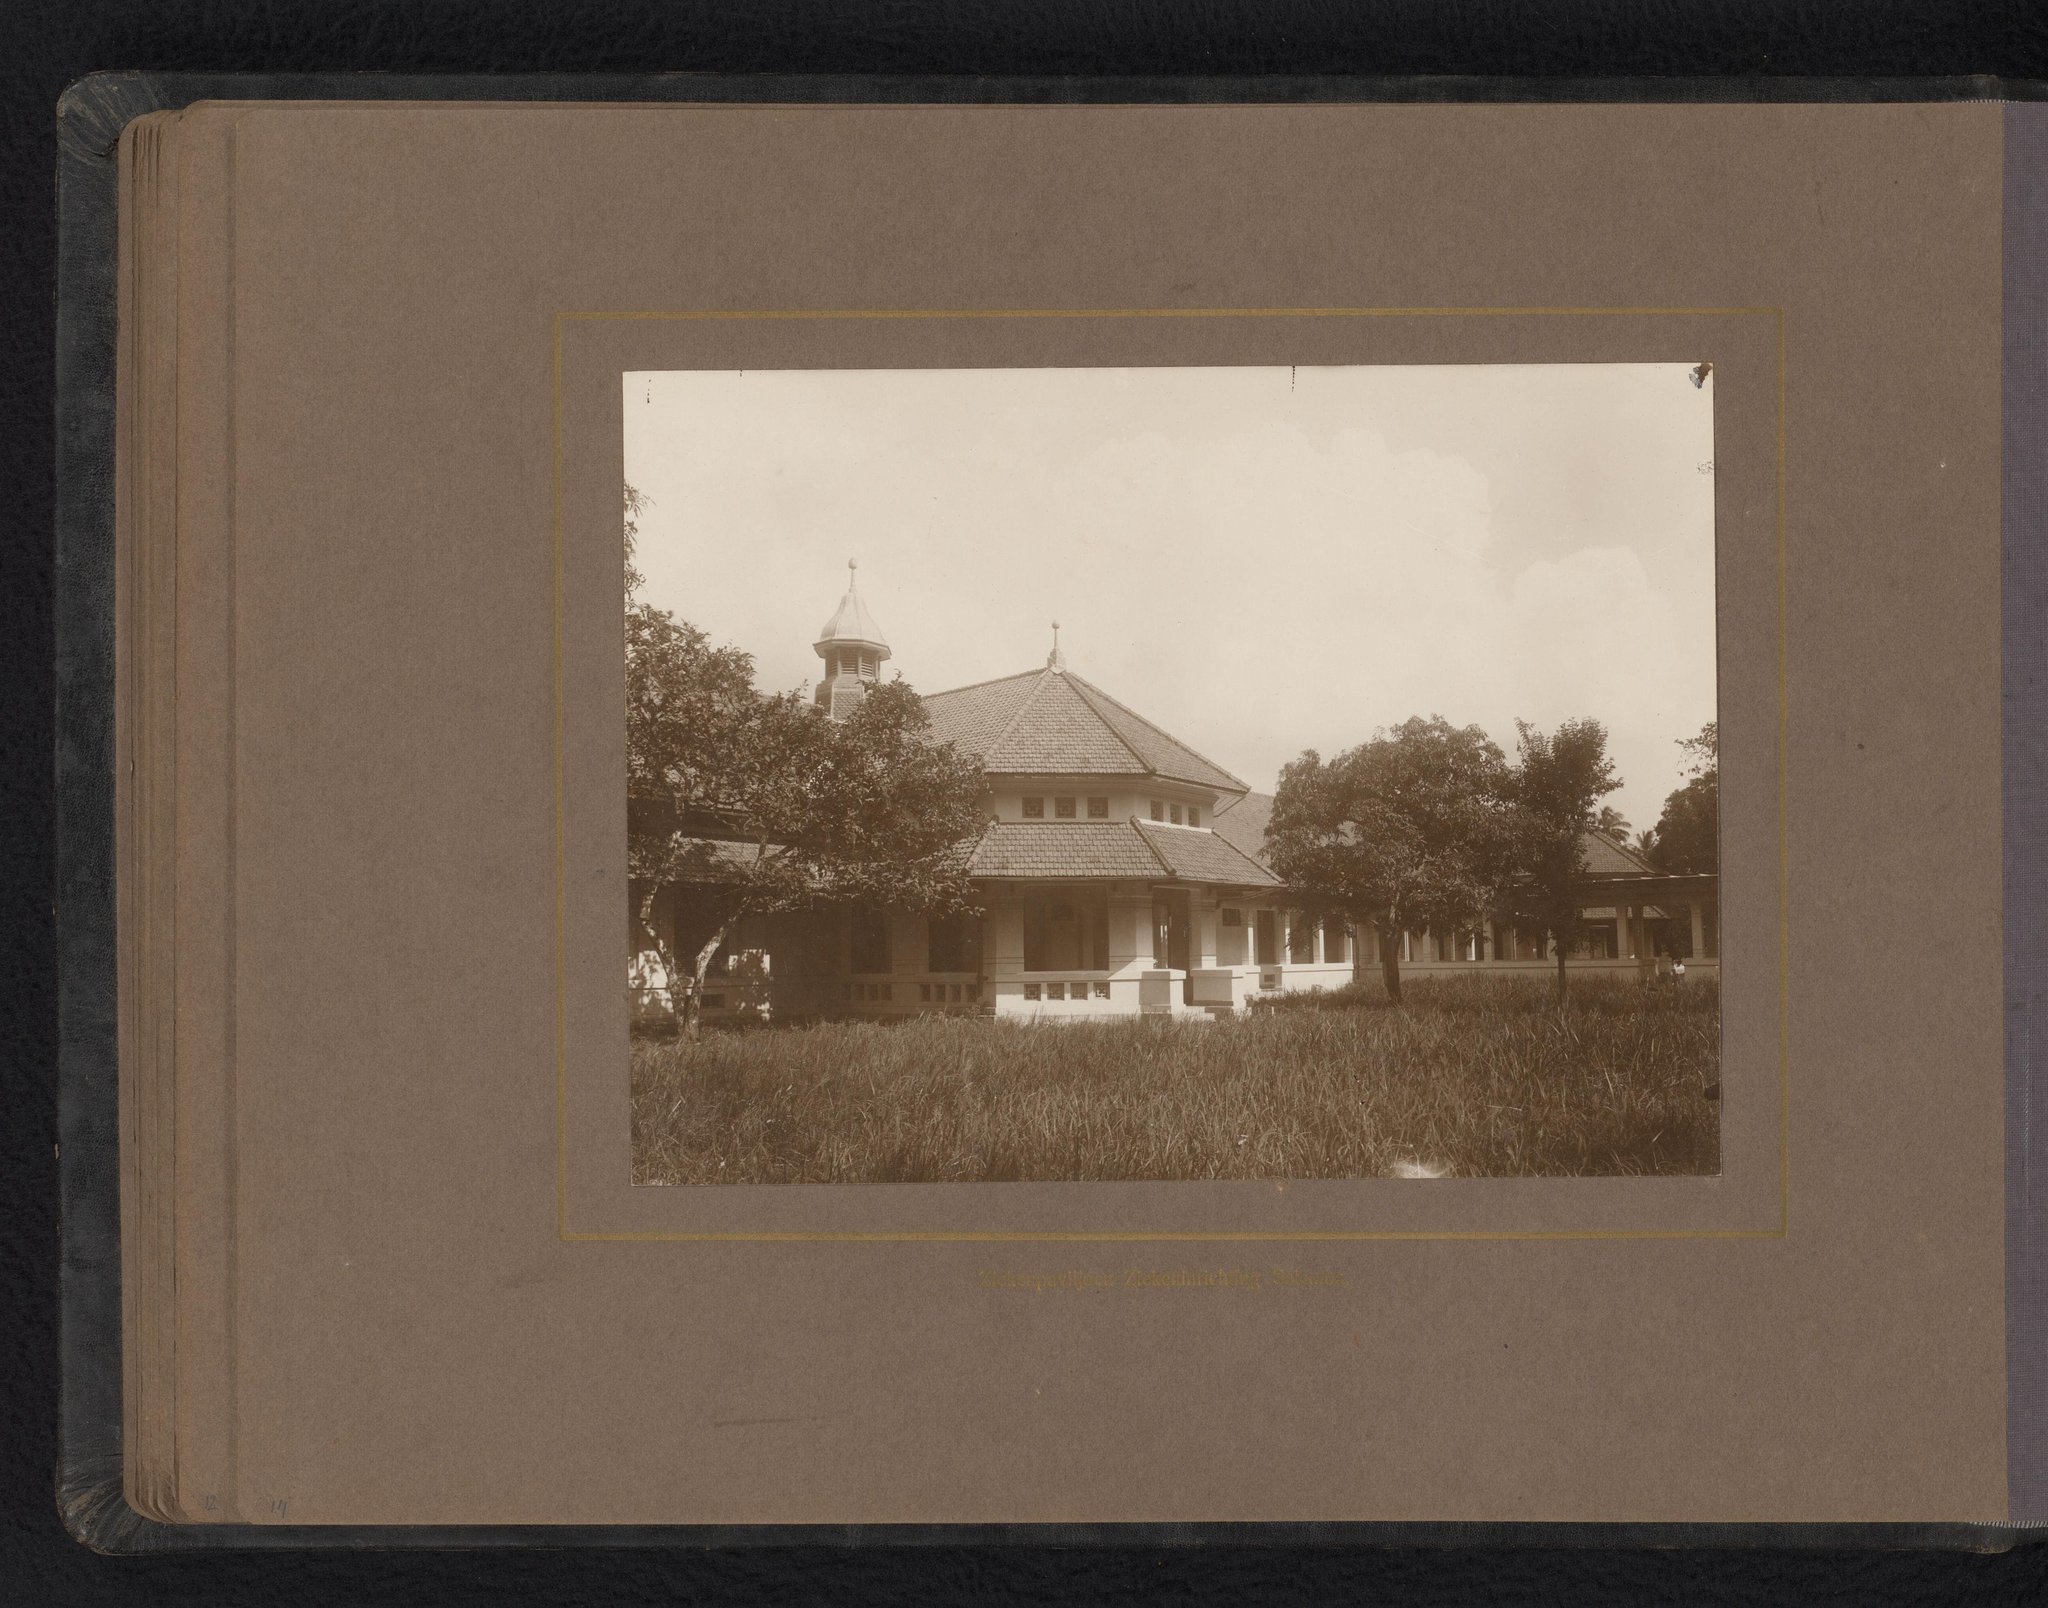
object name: photograph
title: Ziekenpaviljoen Ziekeninrichting Salemba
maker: Anonymous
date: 1918-1919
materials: photographic support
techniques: gelatin silver print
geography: batavia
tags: hospital, batavia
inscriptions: inscription: ‘Ziekenpaviljoen Ziekeninrichting Salemba’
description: Het ziekenpaviljoen van het ziekenhuis de Centrale Burgerlijke Ziekeninrichting op Salemba, Weltevreden. Onderdeel van het fotoalbum van de Eerste Waterstaatsafdeling op West-Java 22 maart 1915 - 30 juli 1919.